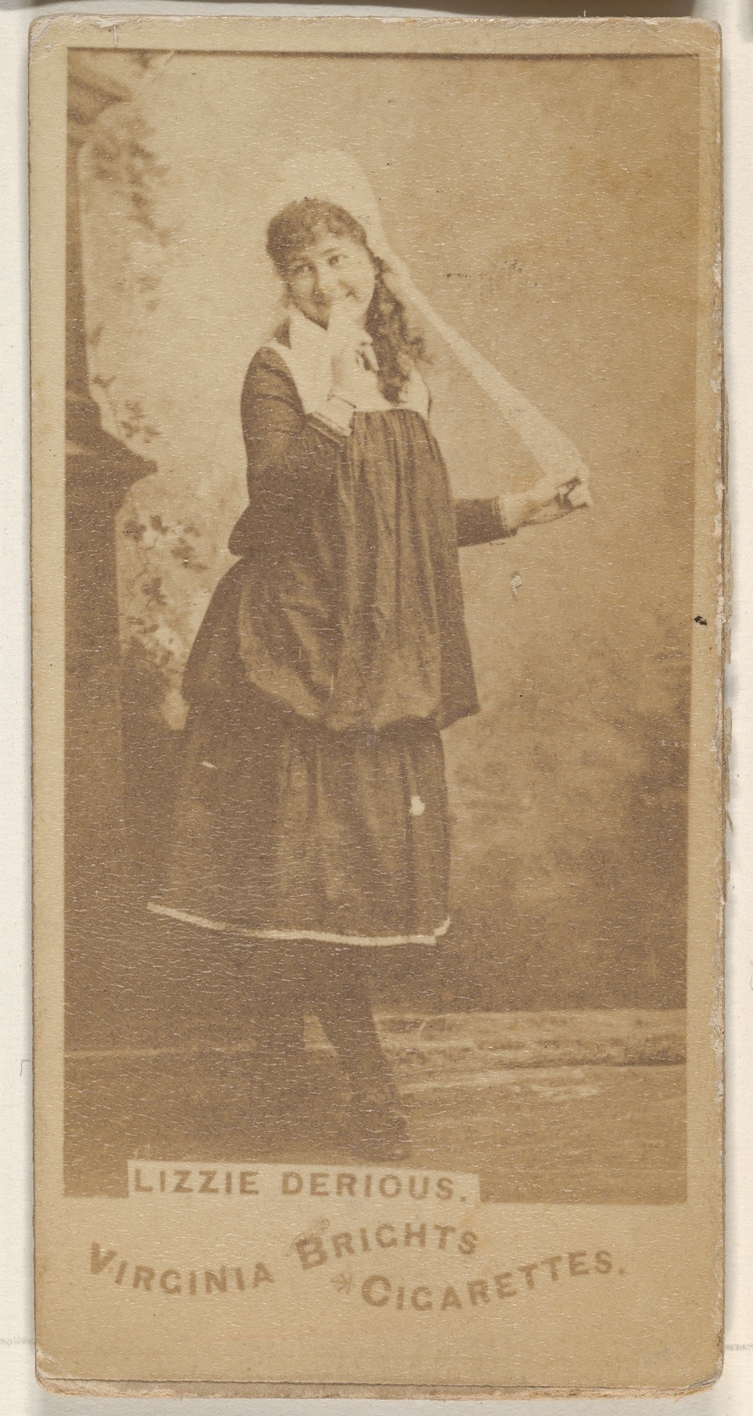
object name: photograph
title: Lizzie Derious, from the Actors and Actresses series (N45, Type 1) for Virginia Brights Cigarettes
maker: allen & ginter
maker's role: publisher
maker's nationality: american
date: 1888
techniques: albumen silver print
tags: portraits,women,actresses